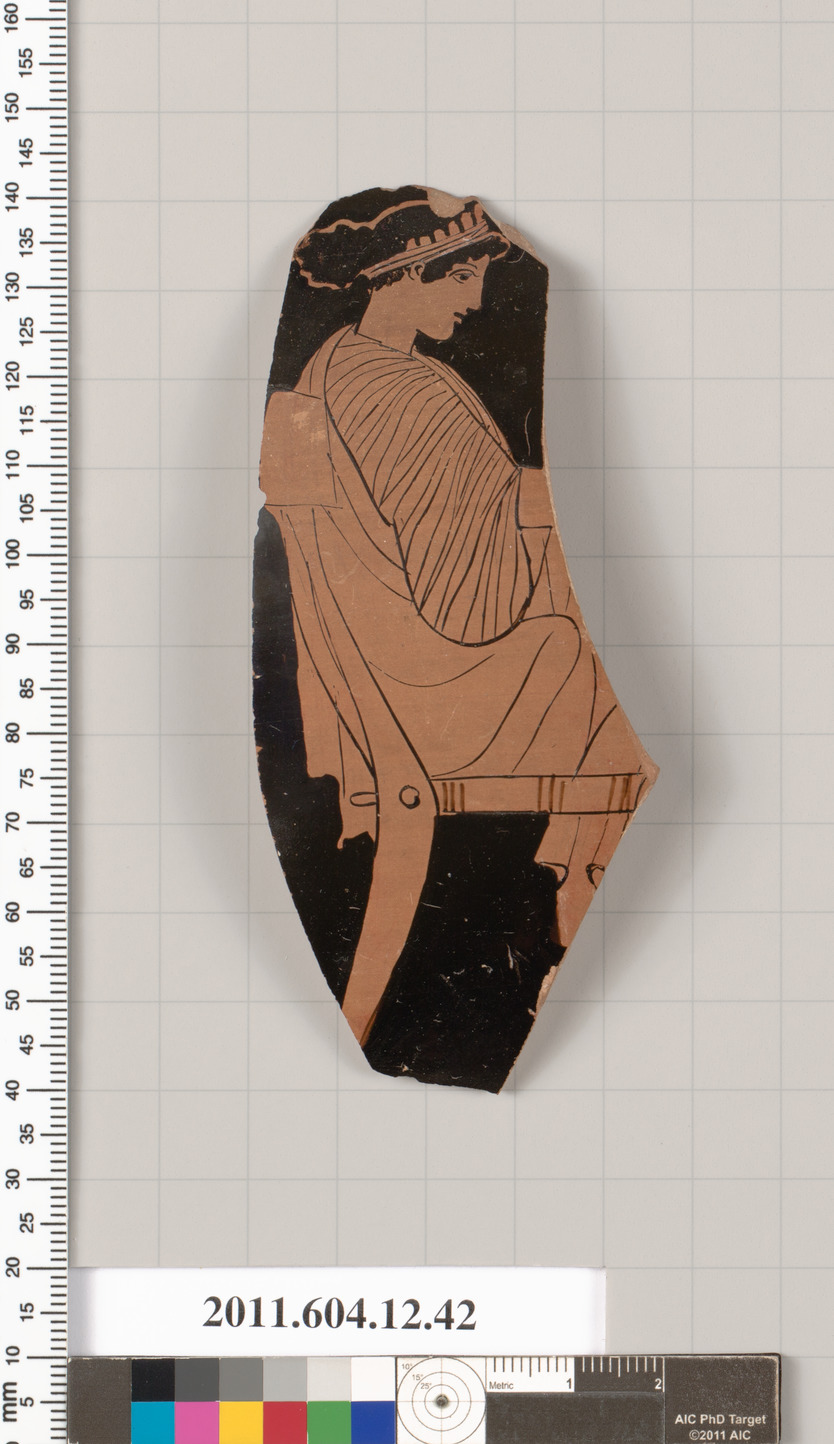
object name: nestoris fragment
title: Terracotta fragment of a nestoris (two-handled jar)?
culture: greek, south italian, lucanian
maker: pisticci painter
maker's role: artist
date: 440-420 BCE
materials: terracotta